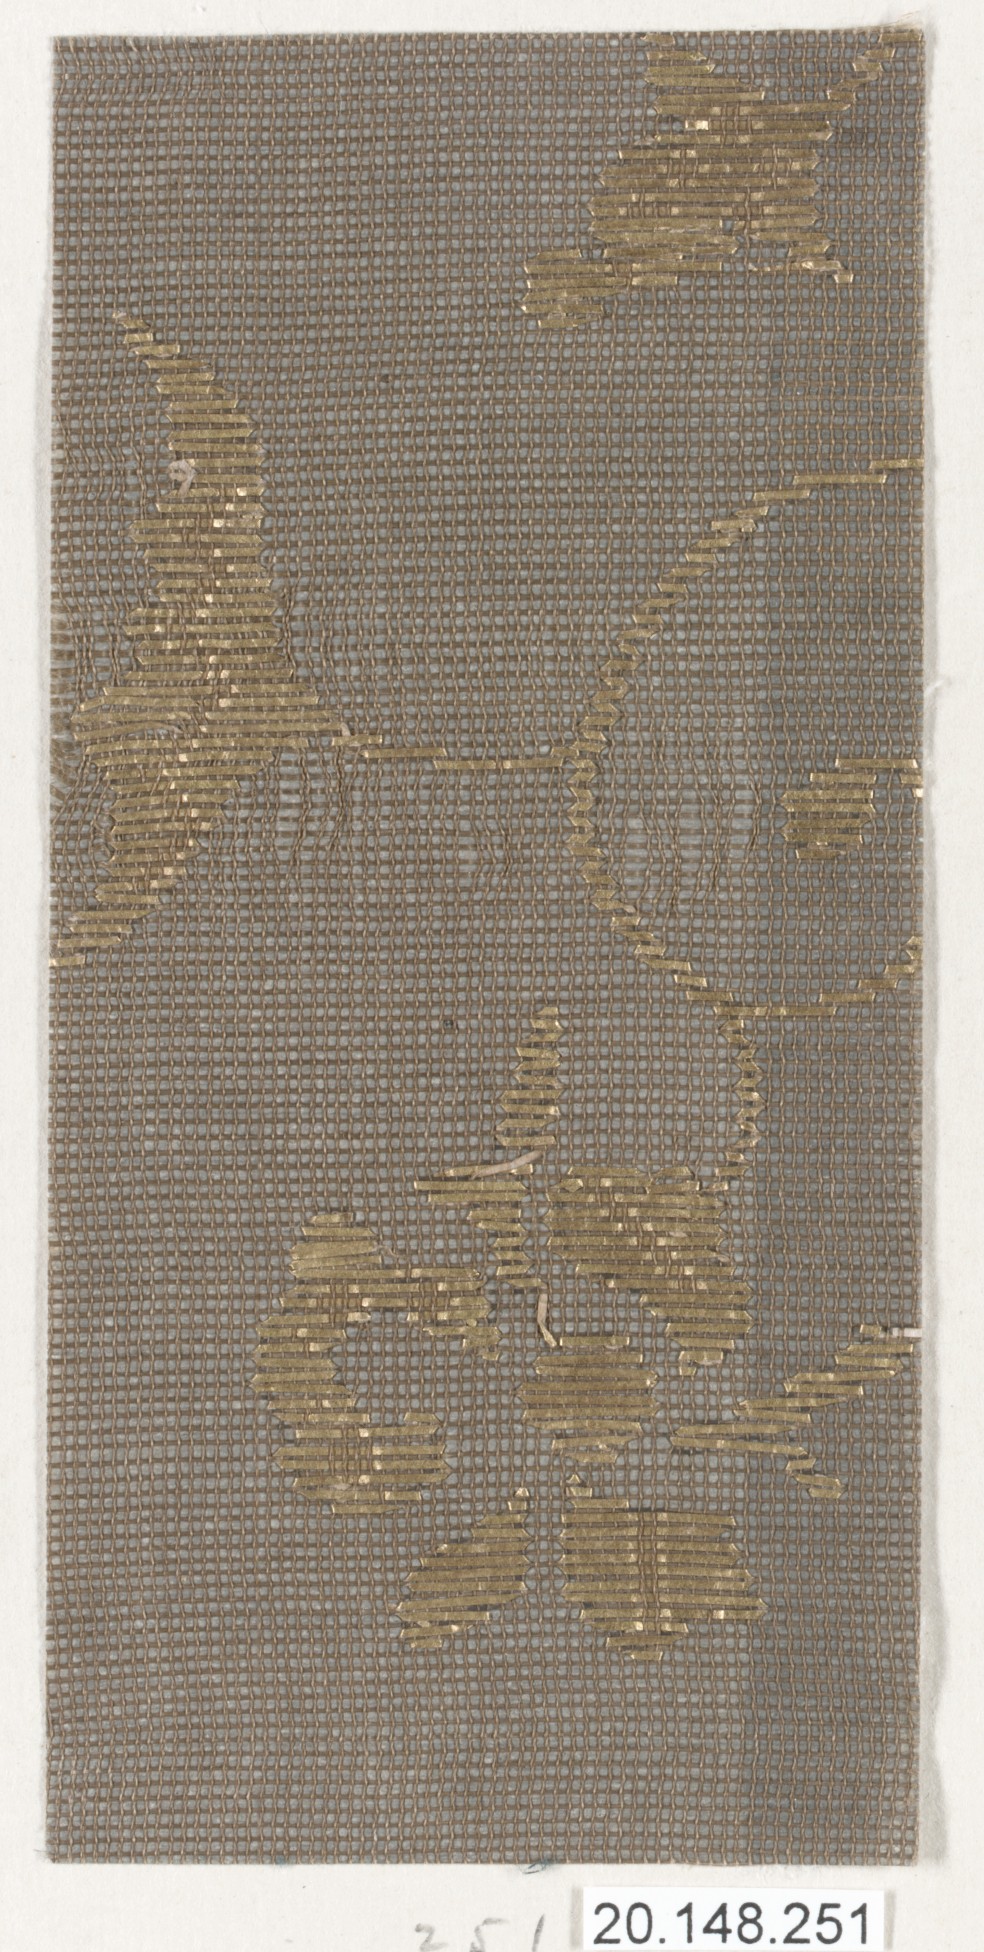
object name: piece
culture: japanese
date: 1701-1800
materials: silk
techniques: compound weave